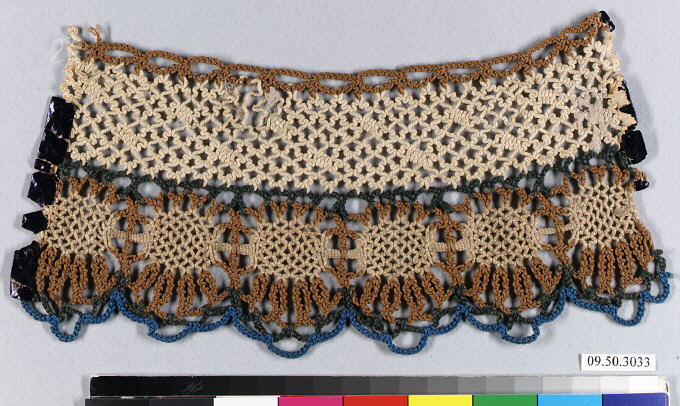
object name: sample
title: Crochet Work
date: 1801-1900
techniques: crochet